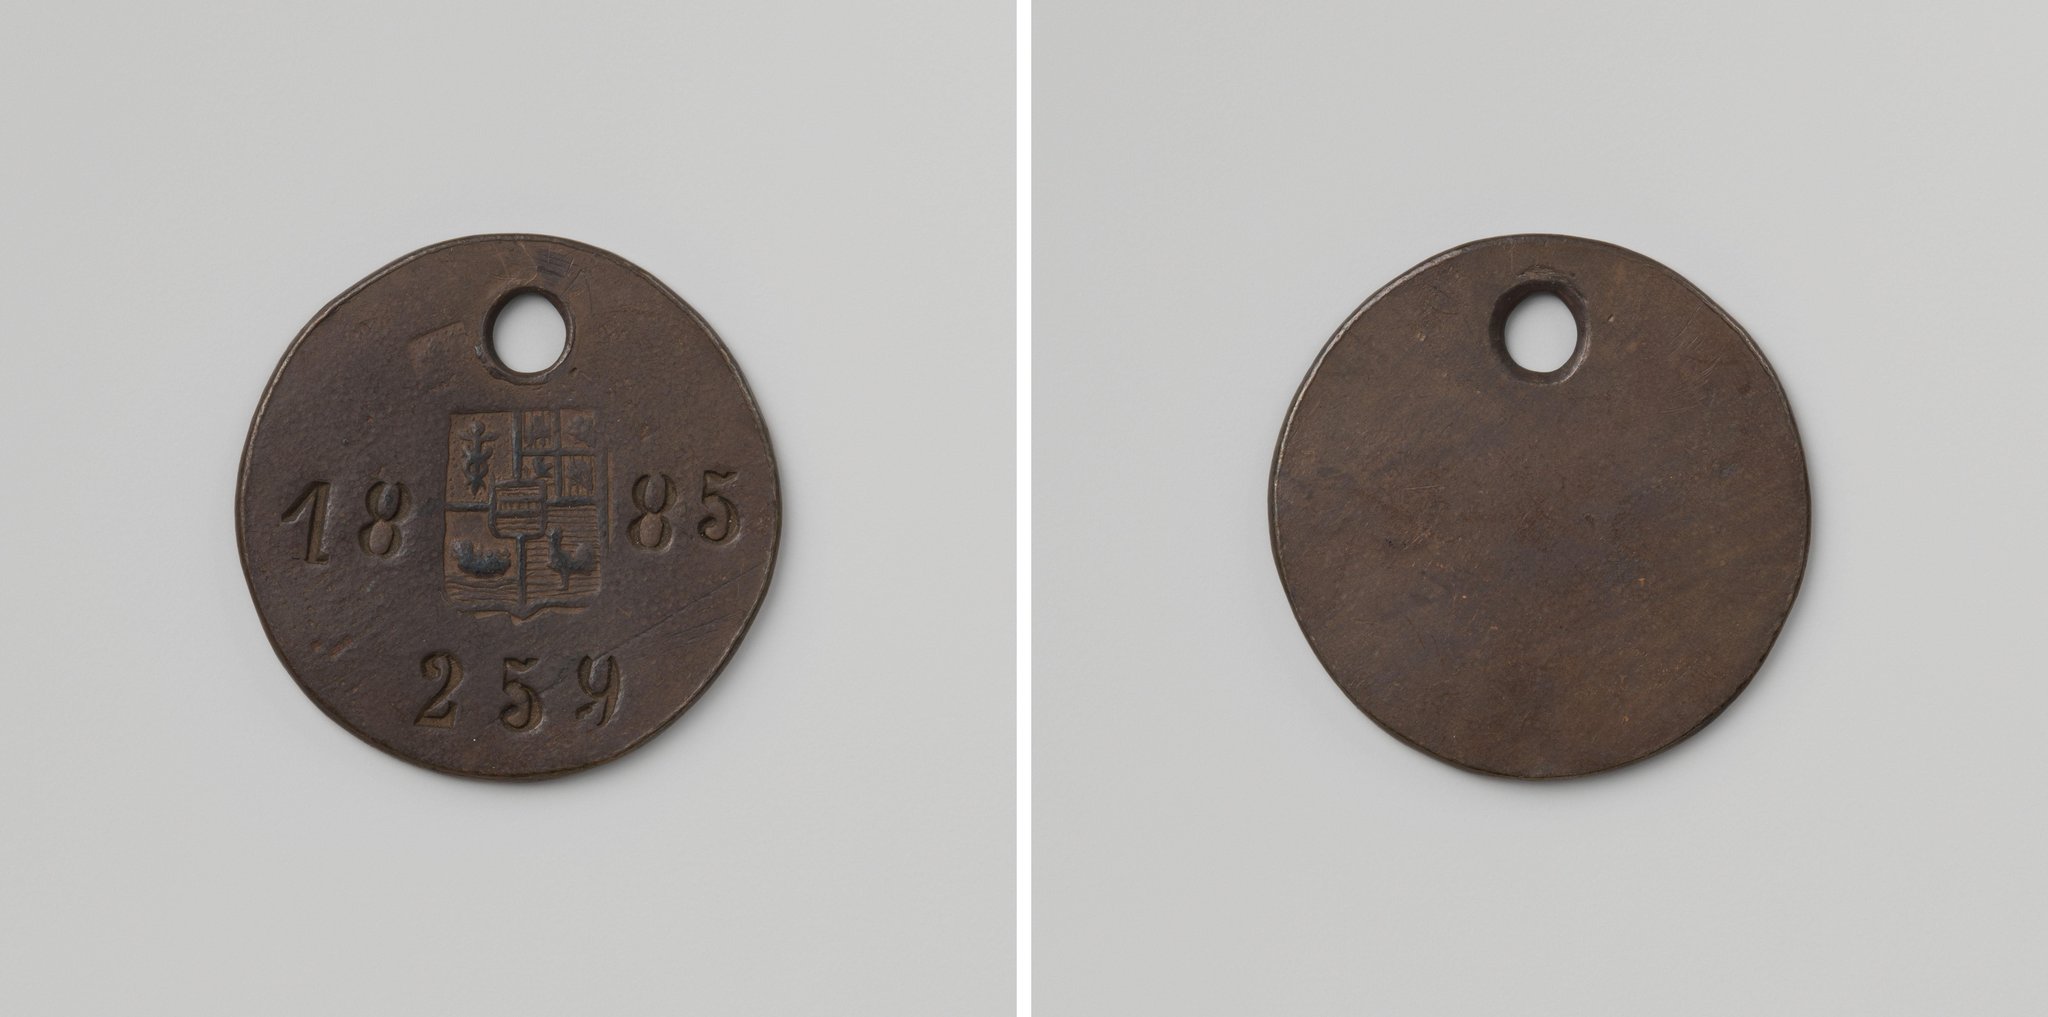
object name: tax token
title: Loodje met no. 259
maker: Anonymous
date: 1885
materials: copper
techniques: striking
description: eenzijdig loodje met gat erin. Voorzijde: wapenschild tussen jaartal boven cijfer 259. Keerzijde: blanco